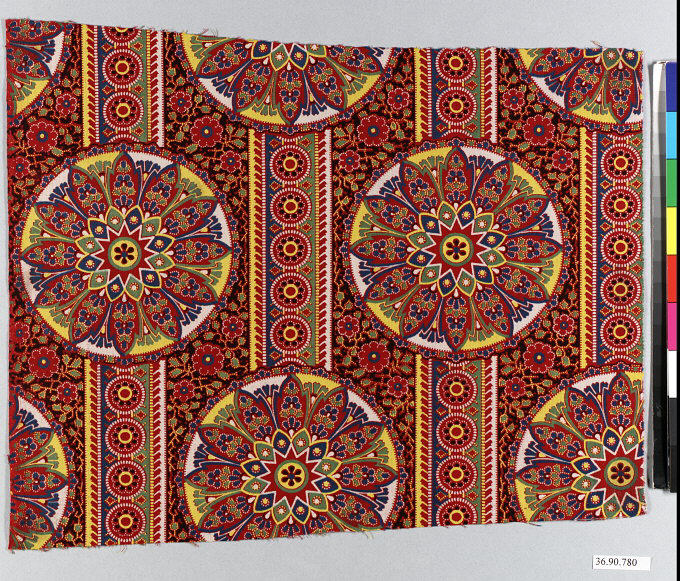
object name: piece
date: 1867-1900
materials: cotton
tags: flowers